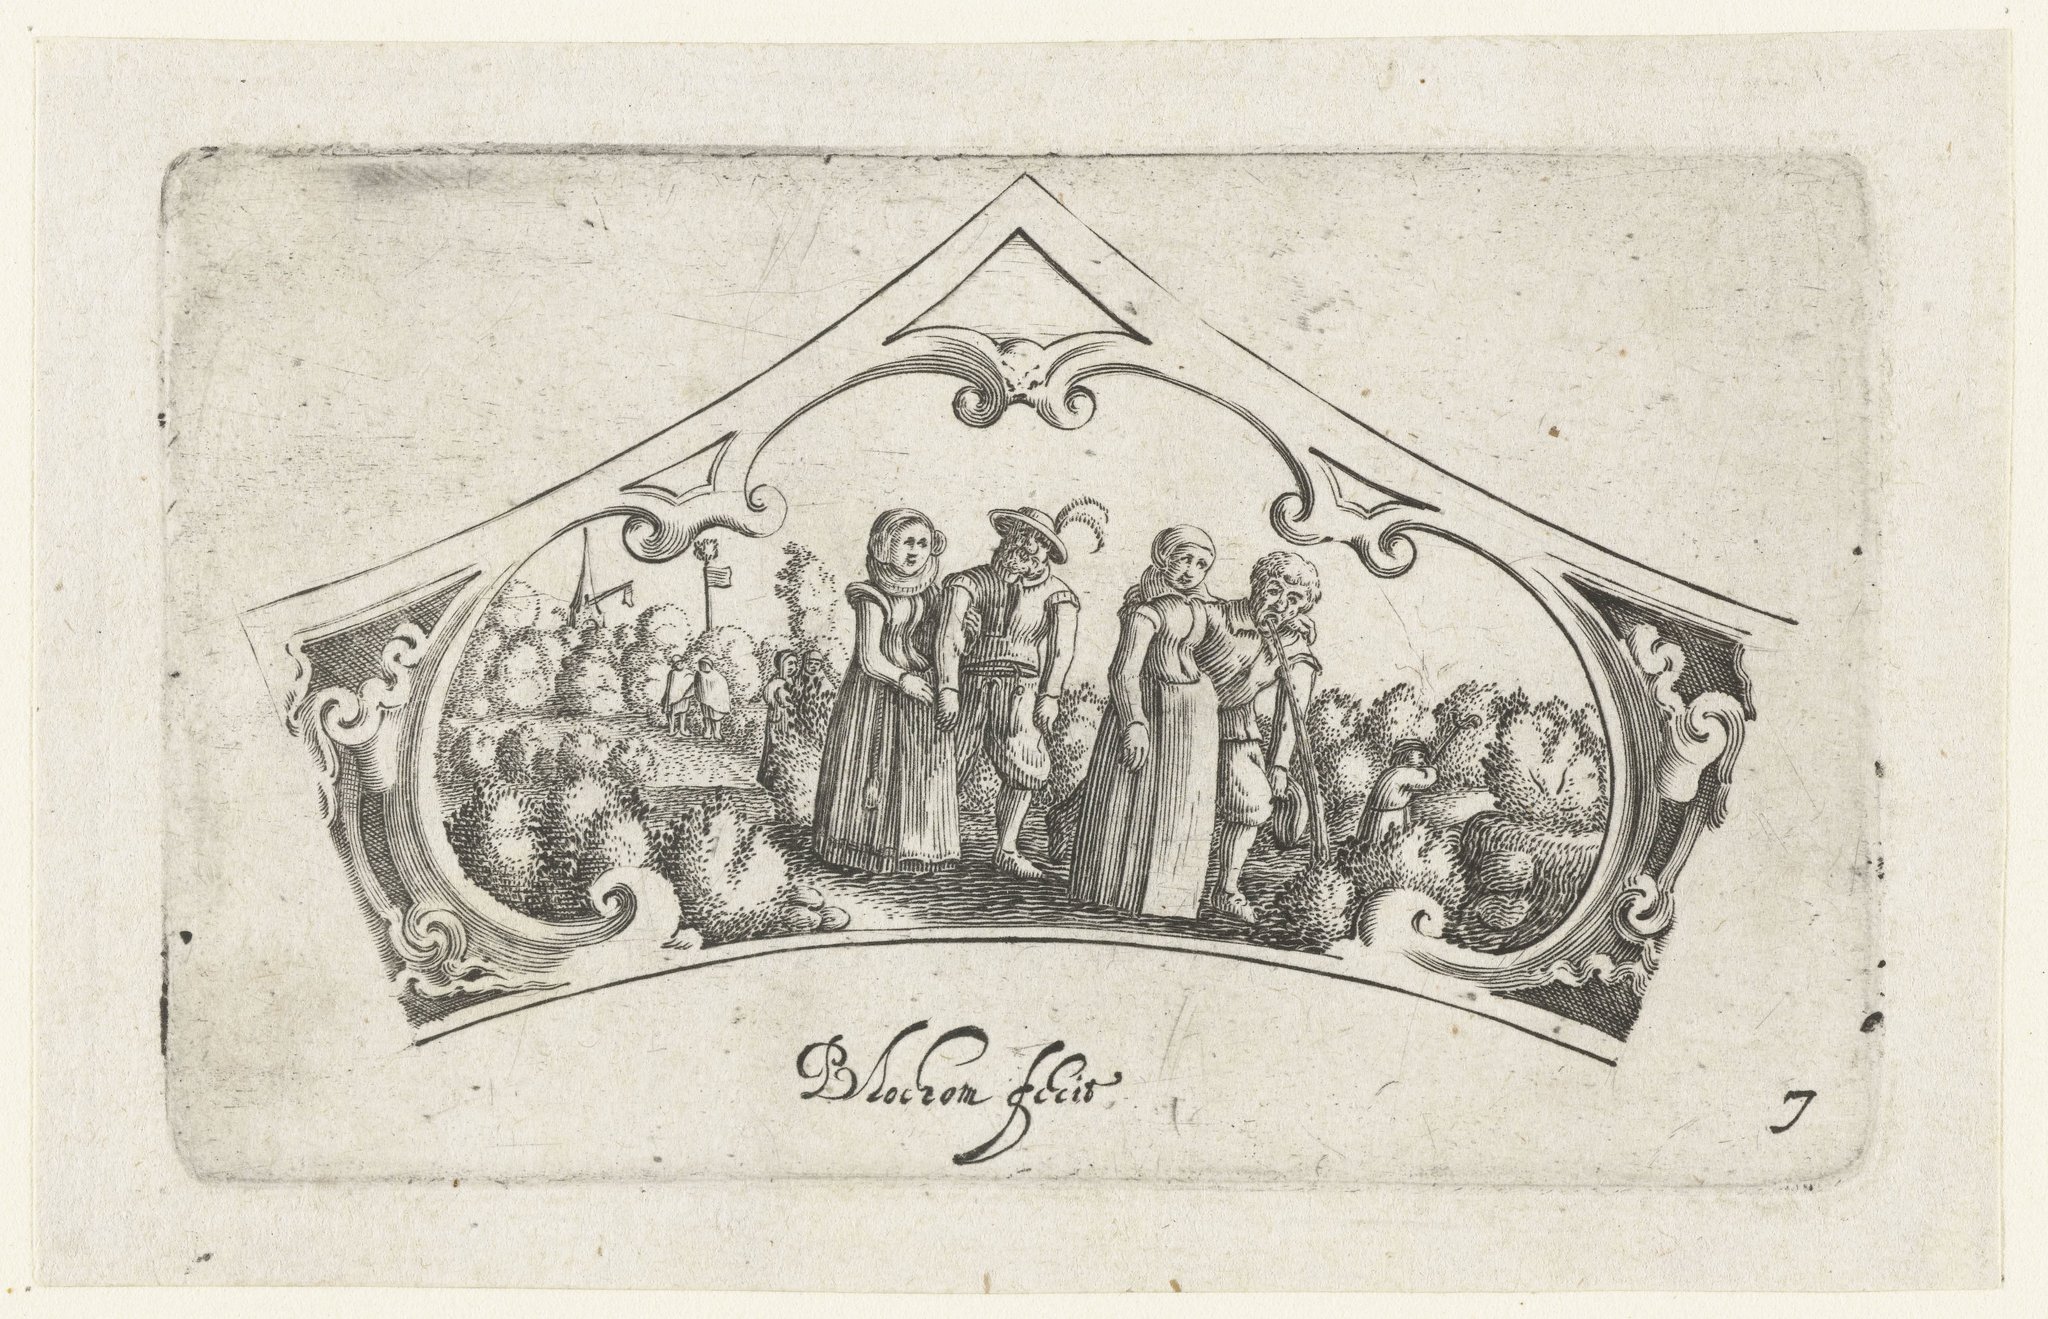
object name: print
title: Twee paren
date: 1630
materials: paper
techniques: engraving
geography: amsterdam